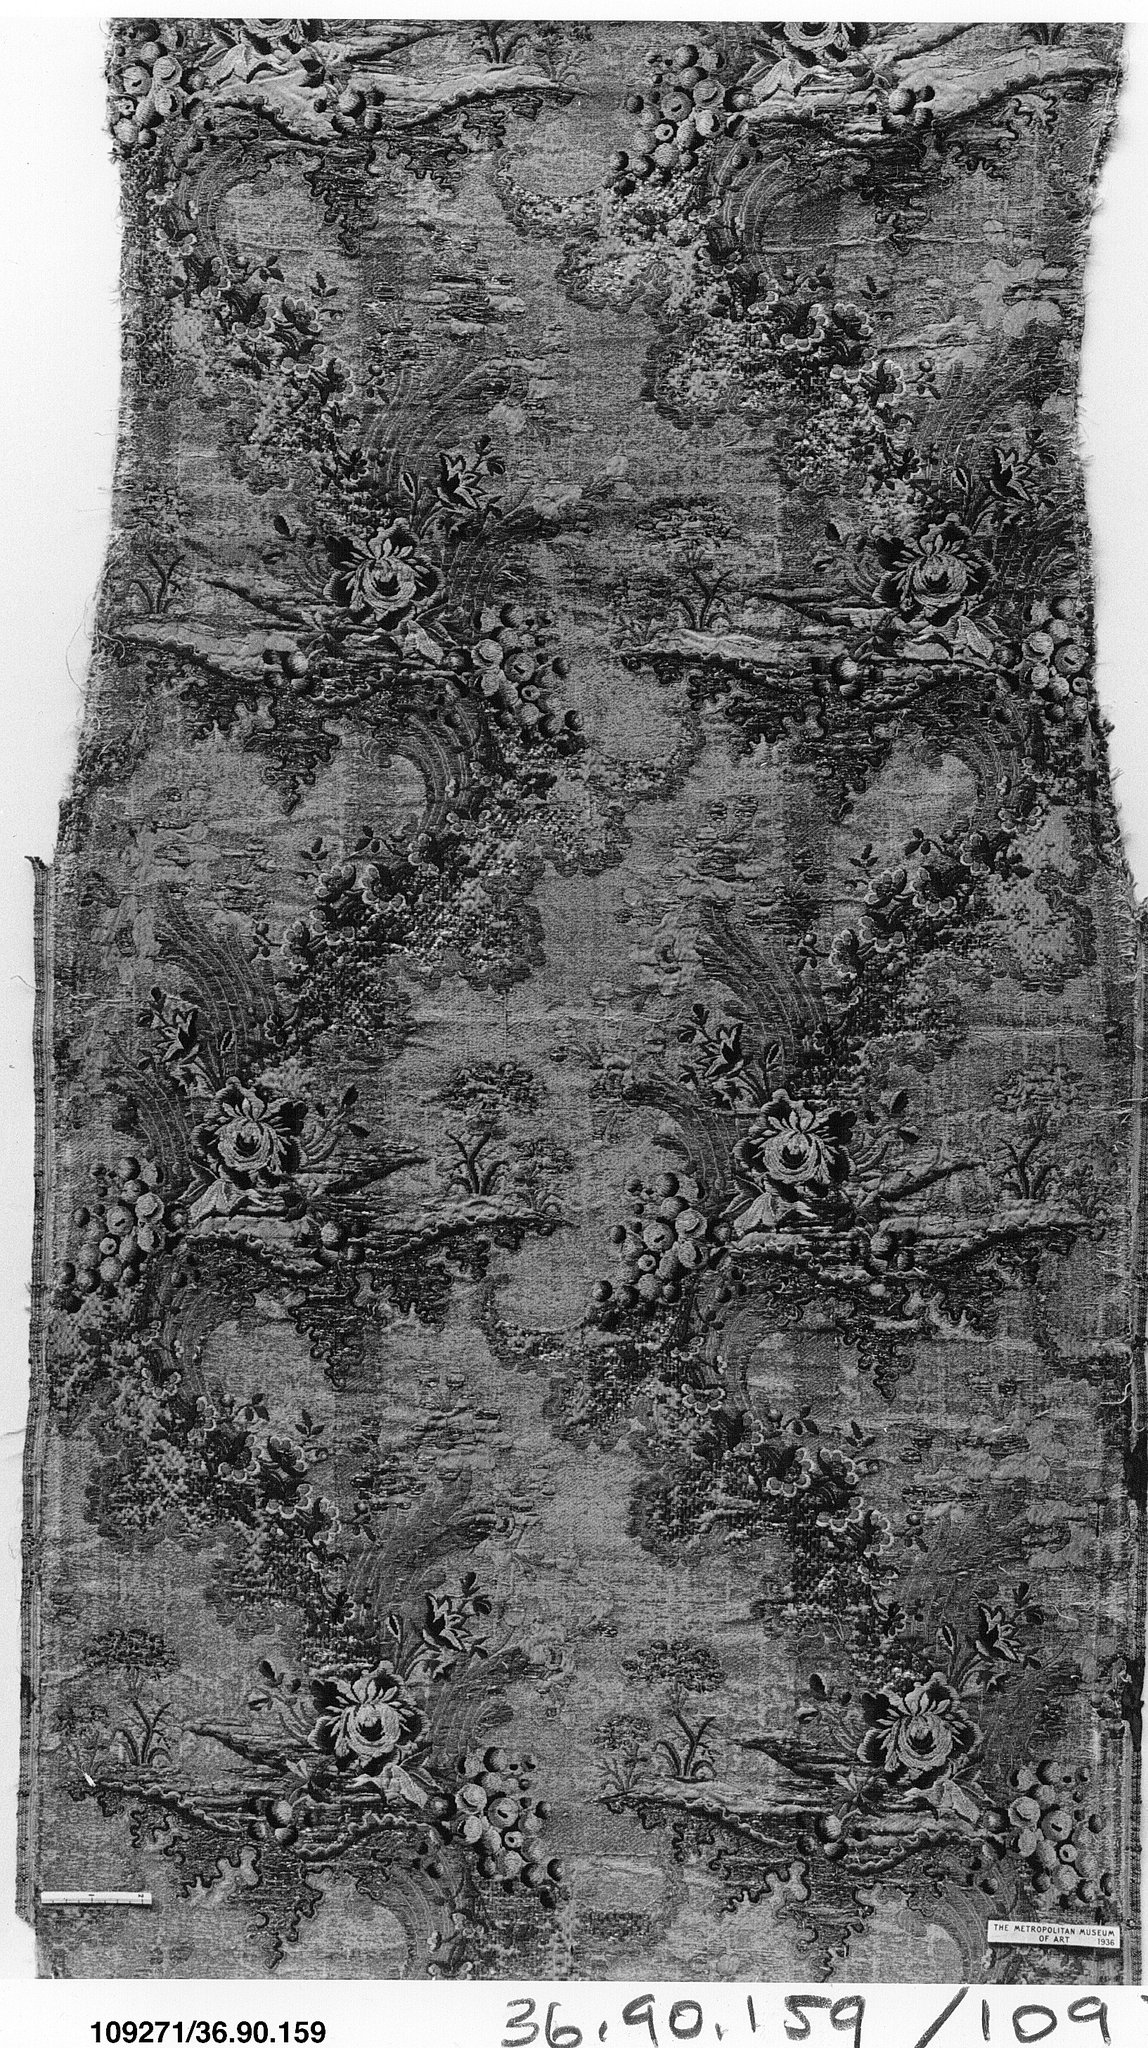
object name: piece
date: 1745-1750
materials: metal thread, silk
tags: fruit,flowers,leaves